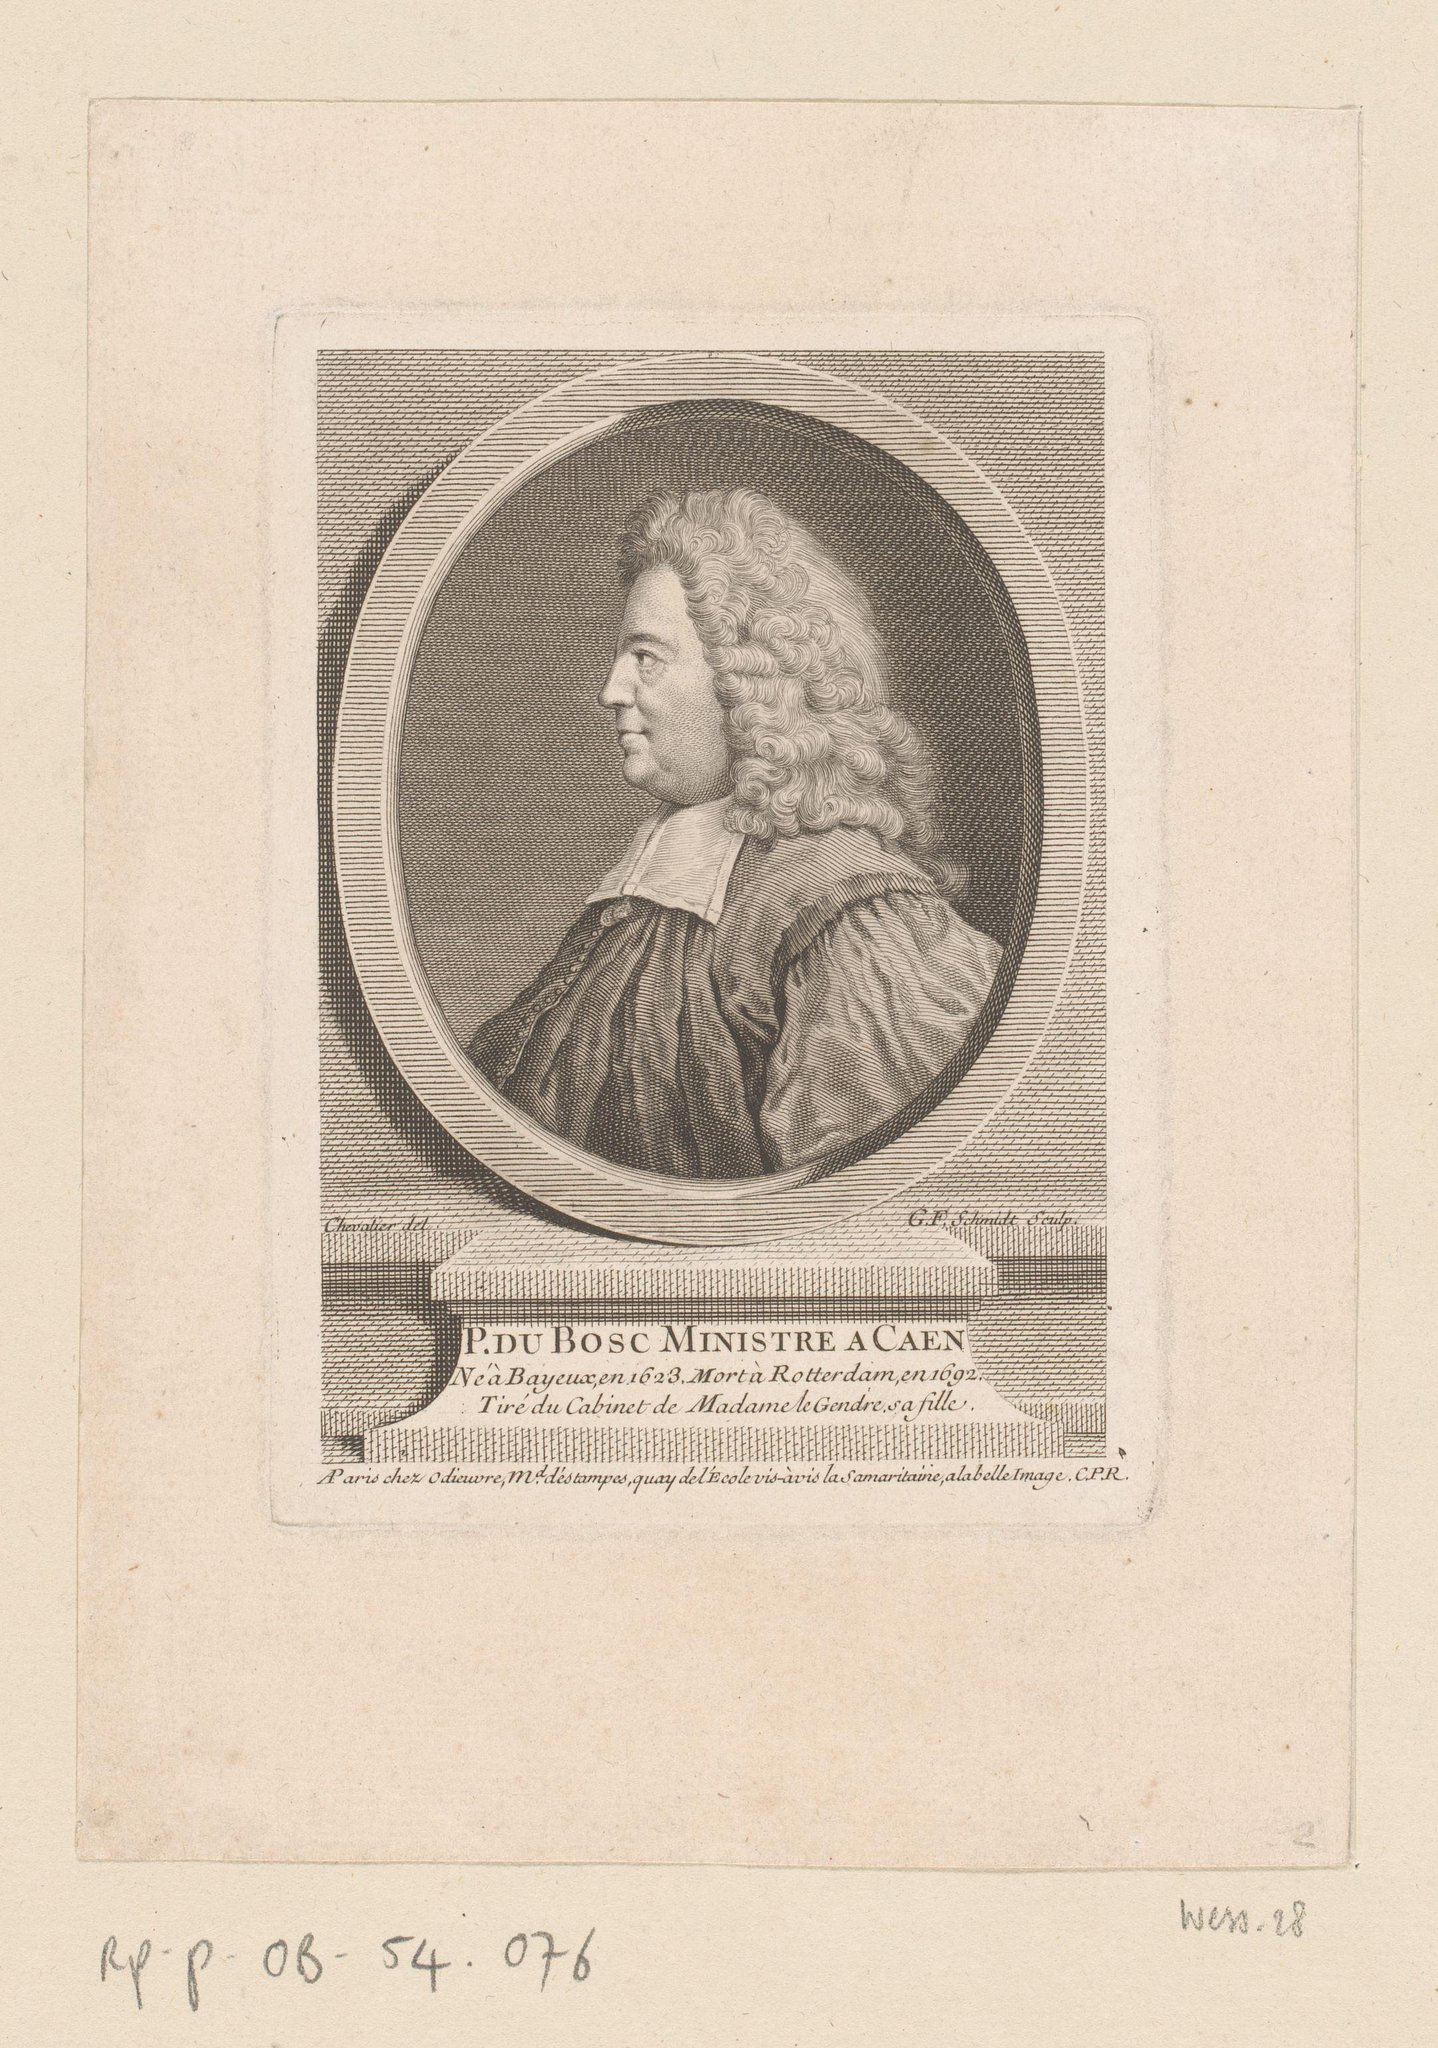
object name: print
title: Portret van Pierre du Bosc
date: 1722-1775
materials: paper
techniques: engraving, etching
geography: paris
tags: rotterdam, priest, pierre du bosc, theologian, historical persons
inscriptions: collector's mark: Lugt 240